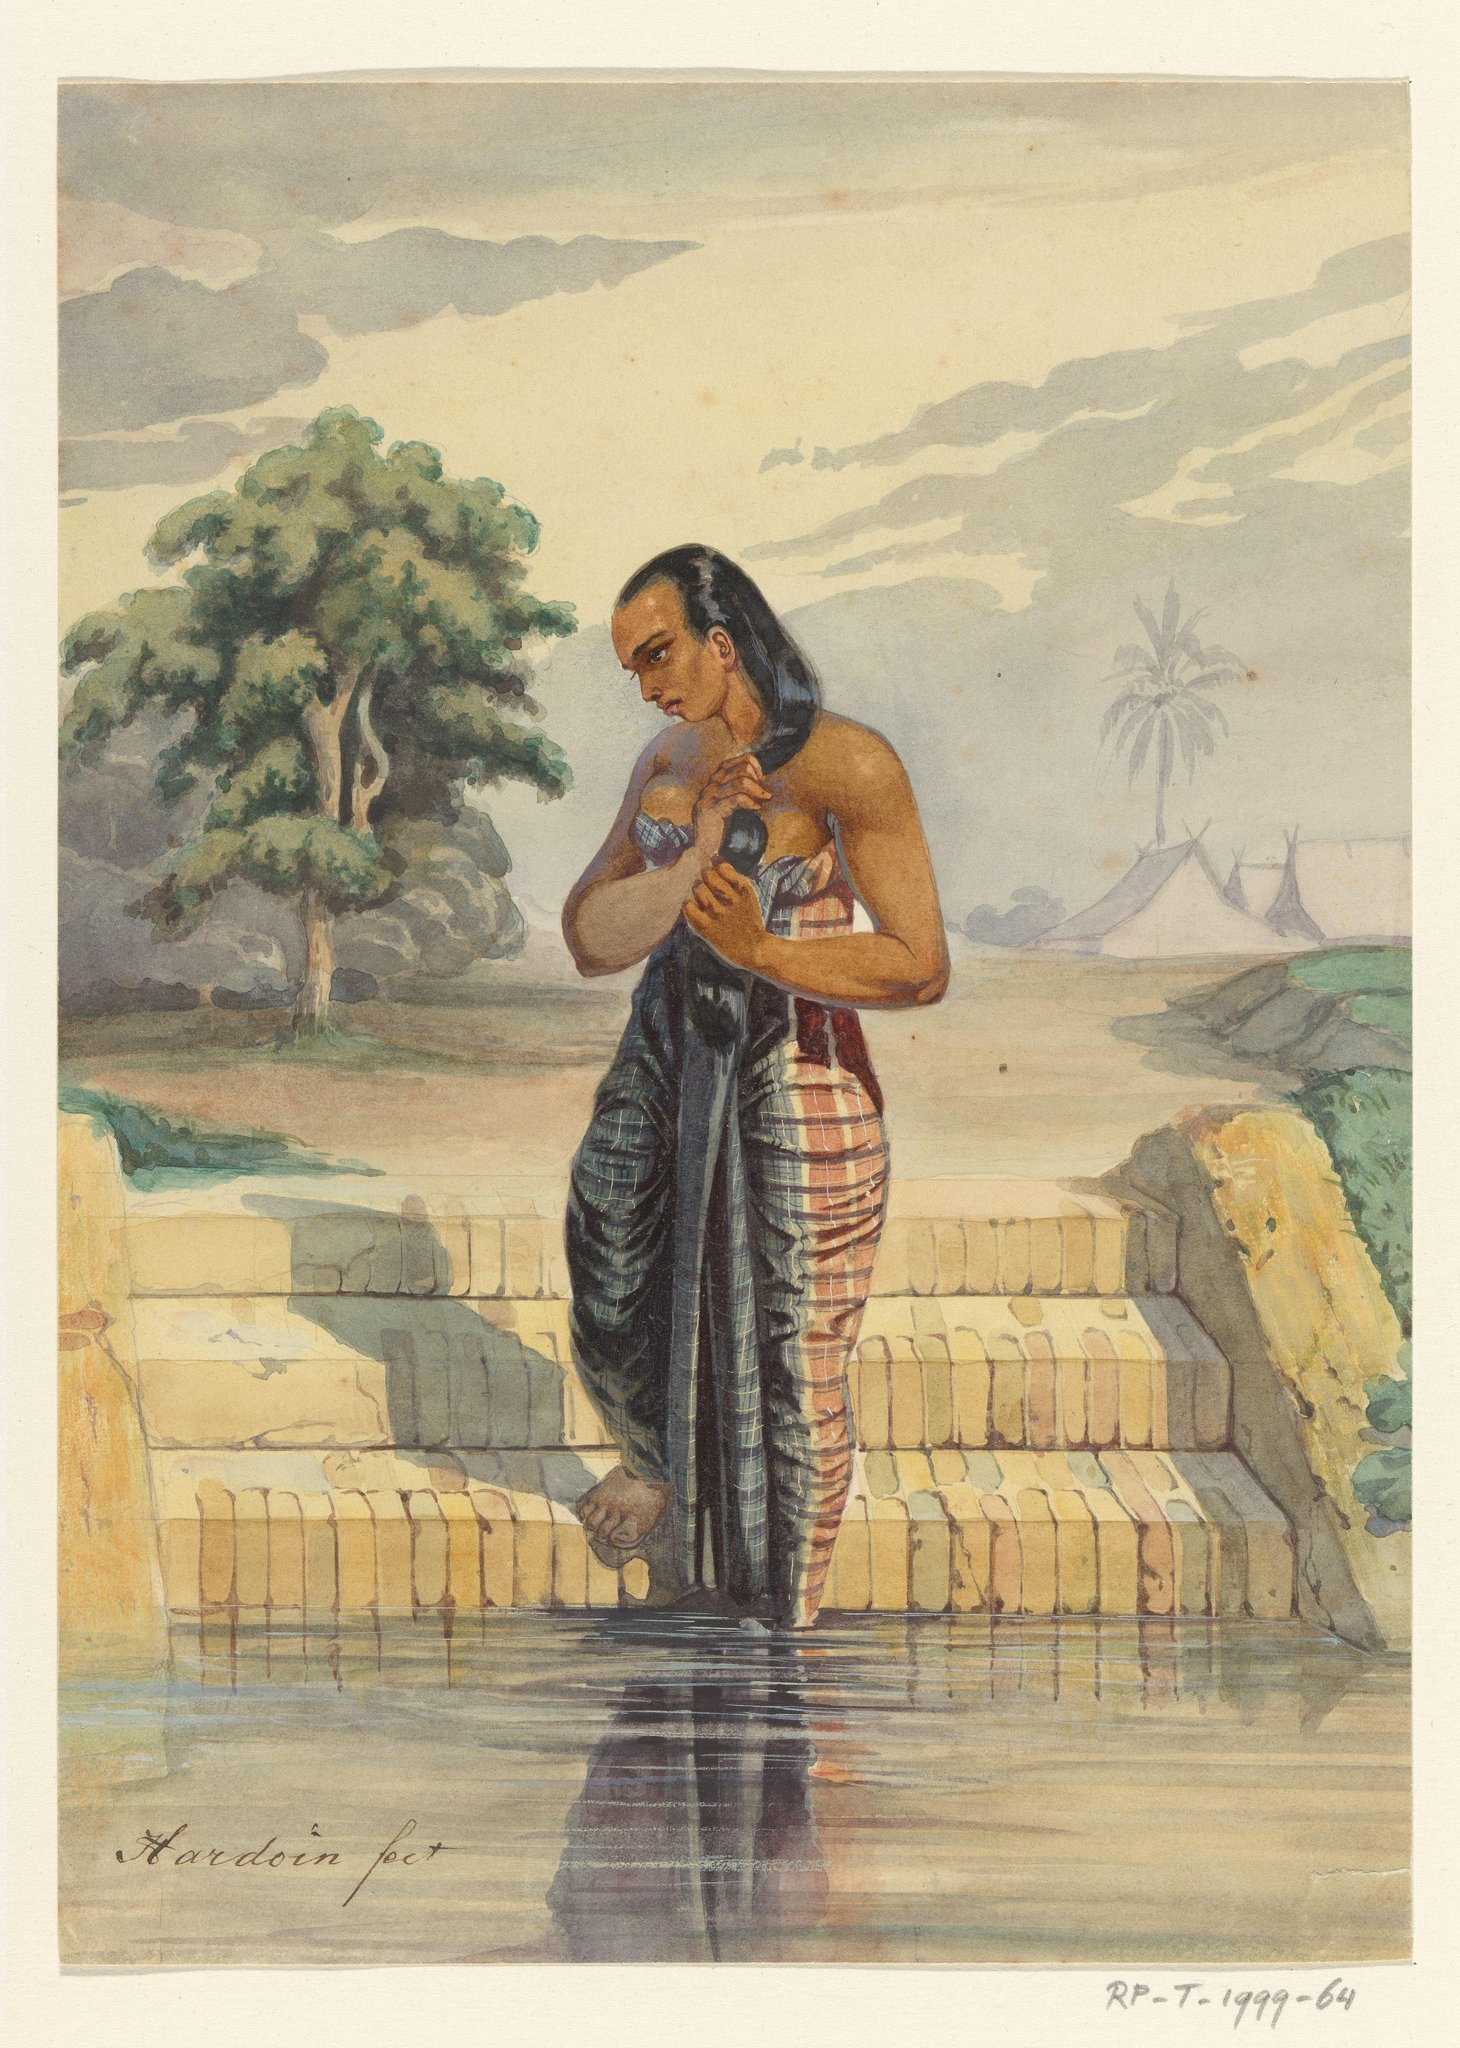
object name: drawing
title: Badende Javaanse slavin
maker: ernest alfred hardouin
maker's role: draughtsman, painter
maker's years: 1820-1853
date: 1837-1854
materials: paper, pencil, watercolor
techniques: brush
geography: batavia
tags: slavery; serfs and enslaved persons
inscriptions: signature: ‘Hardoin fect’